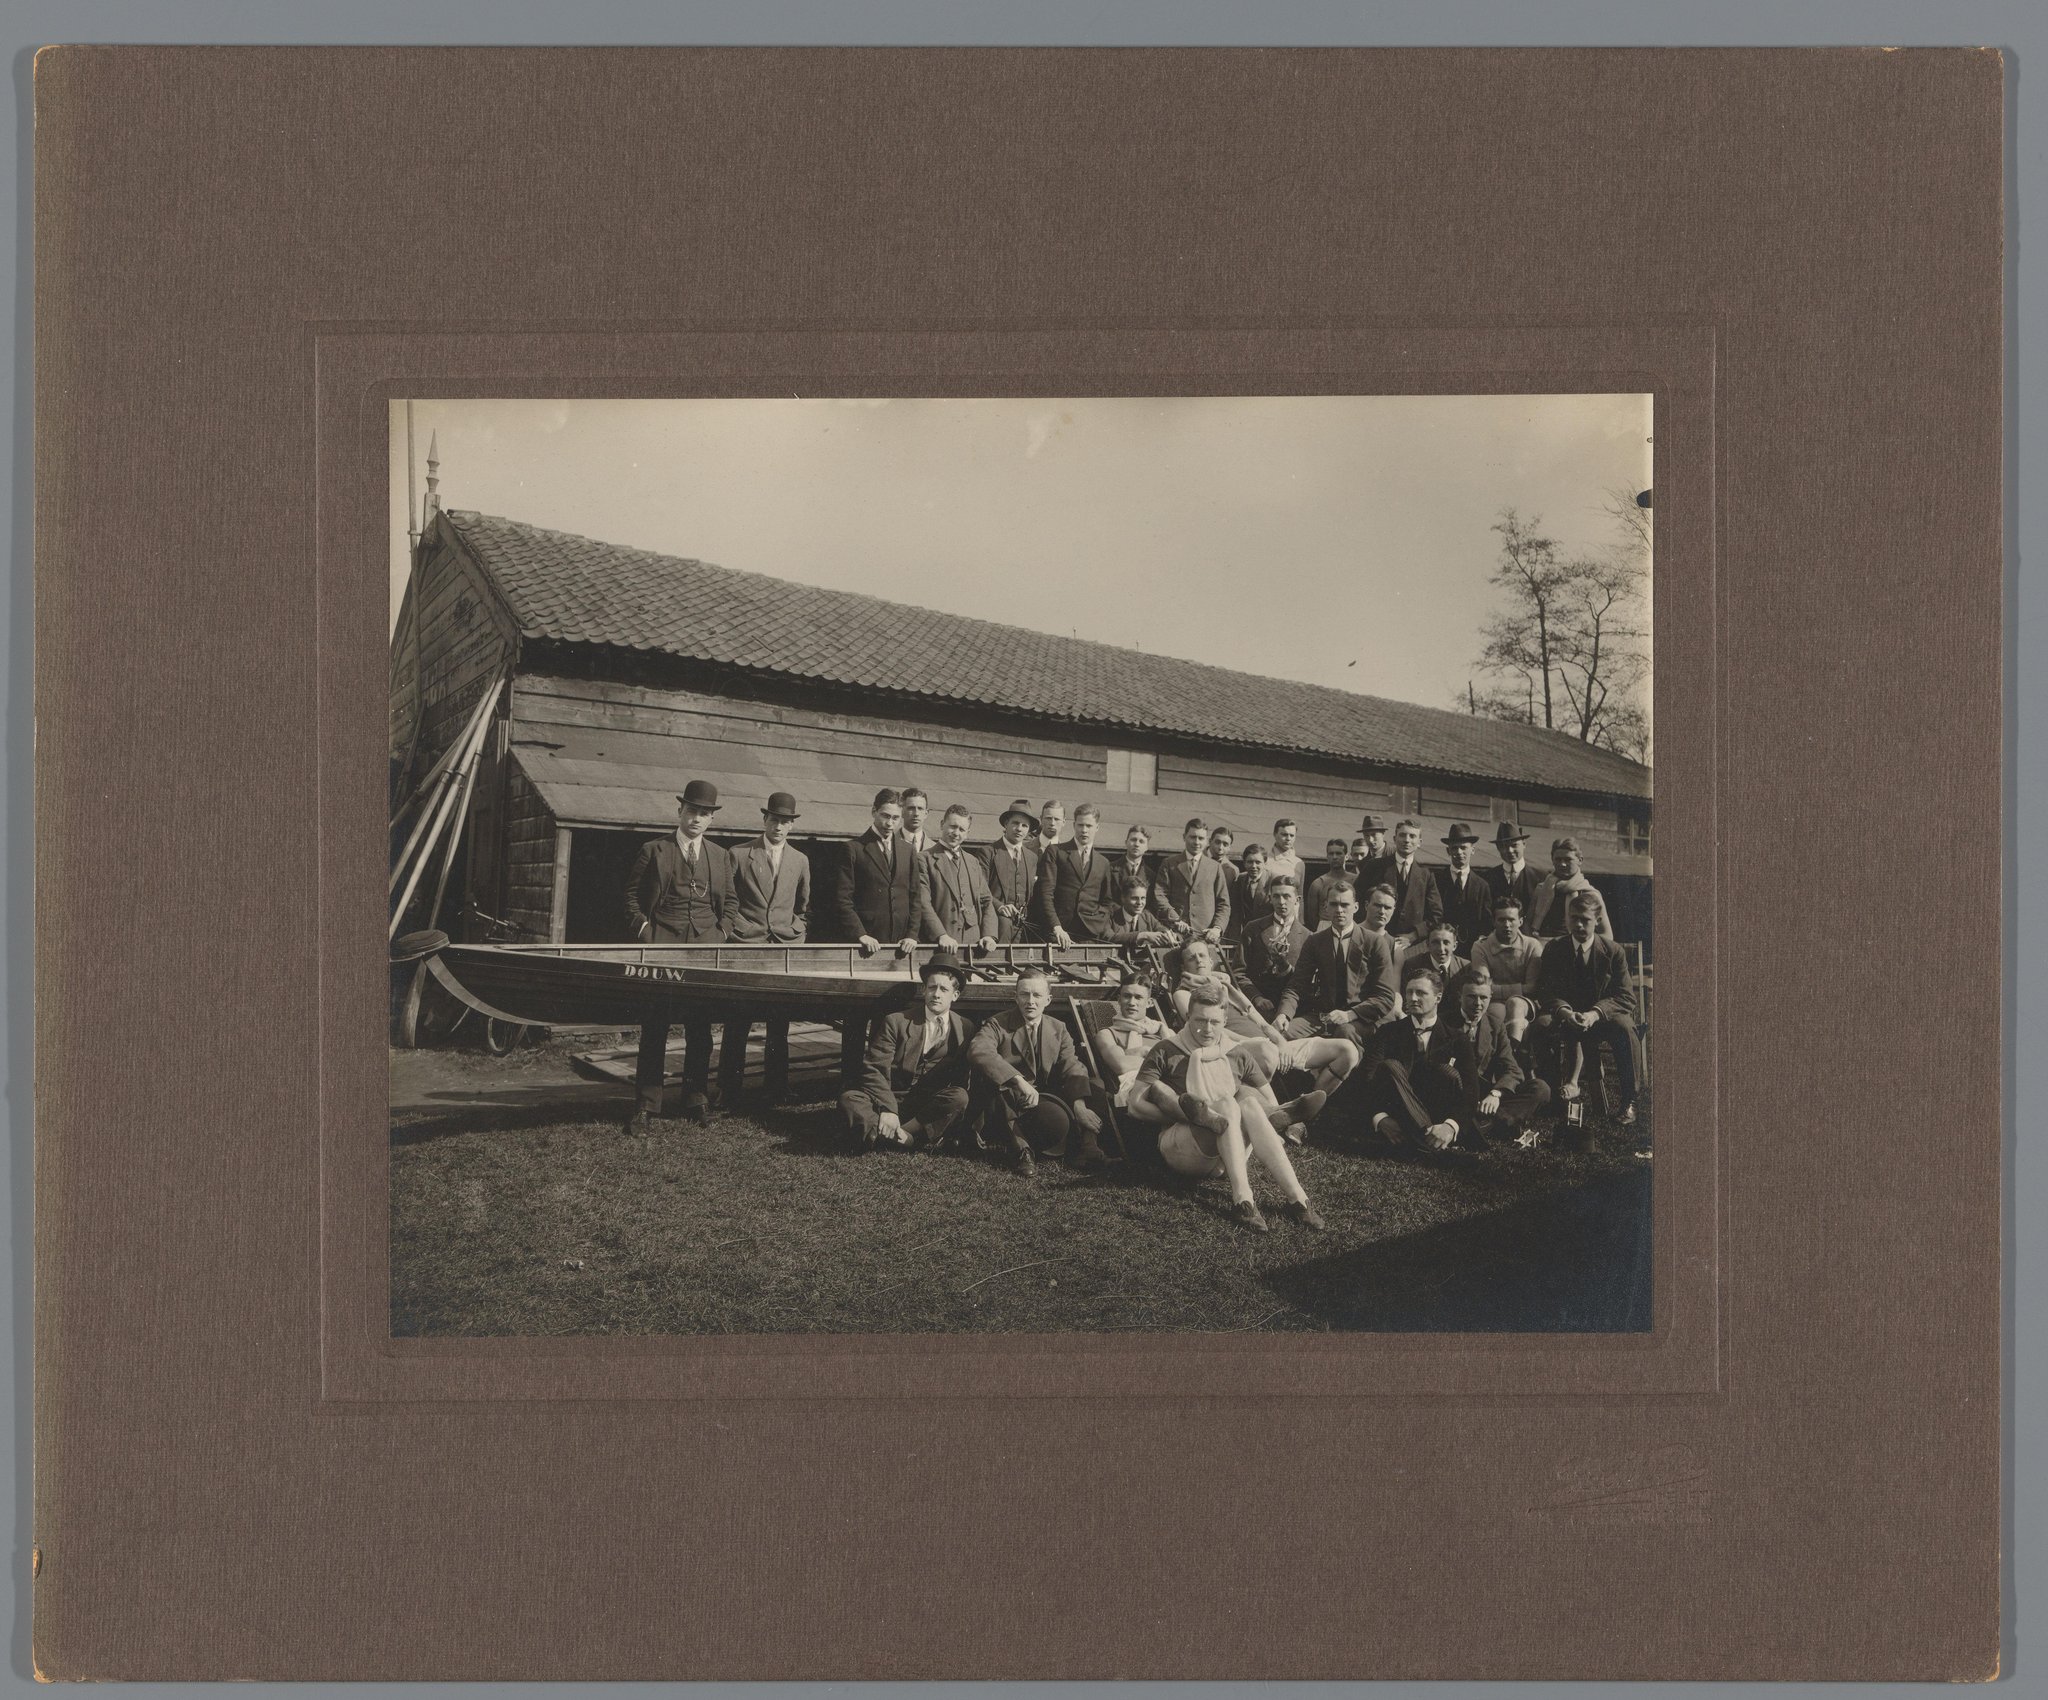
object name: photograph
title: Groepsportret van leden van Laga ter ere van de overdracht van de Douw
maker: Anonymous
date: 1918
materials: paper, cardboard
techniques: gelatin silver print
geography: delft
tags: rowing facing backward, pulling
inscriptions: inscription: ‘Overdracht v.d. "Douw"/ Raceroeiers installatie. 21 Maart '18./ staande v.l.n.r. De Vuis. Laarbeek. P.../ zittend v.l.n.r./ v Deloden. [...]’